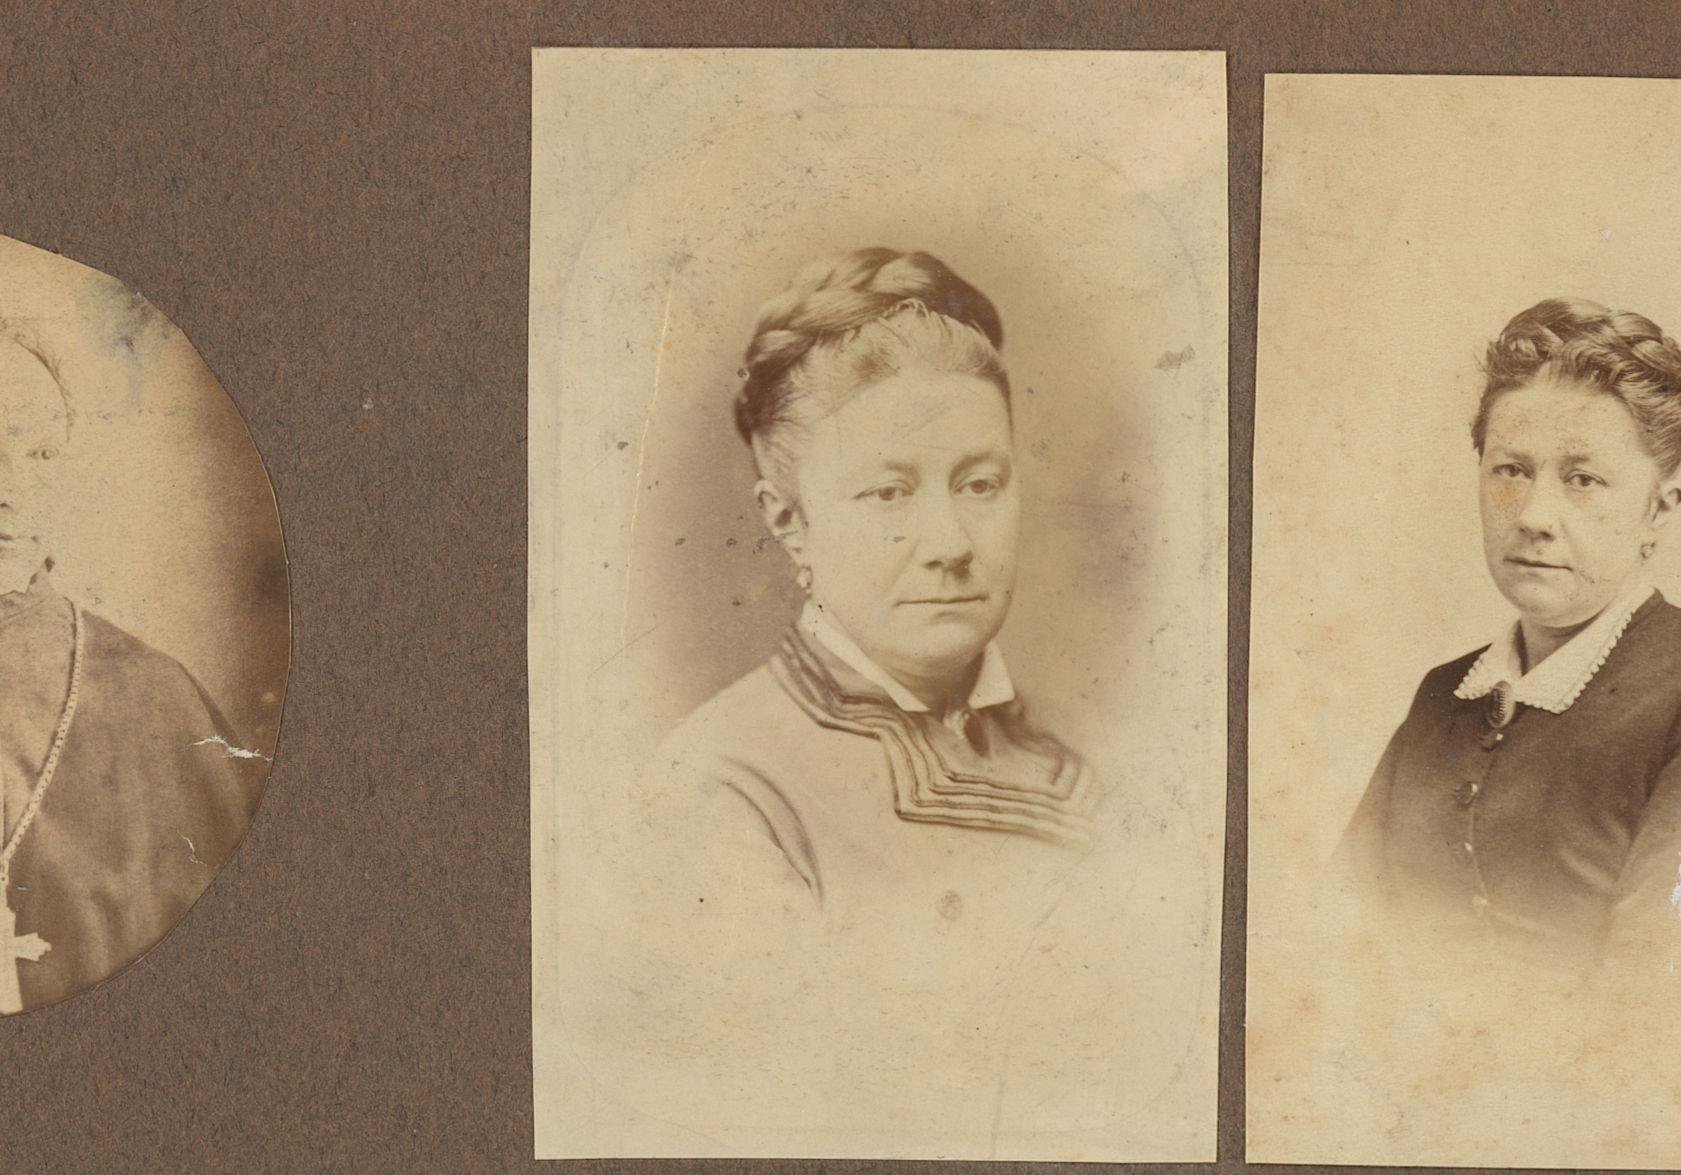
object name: photograph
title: Portret van vrouw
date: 1870-1910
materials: photographic support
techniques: photography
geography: netherlands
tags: netherlands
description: Foto op bruin albumblad 30 van familiealbum van Alphons Diepenbrock.